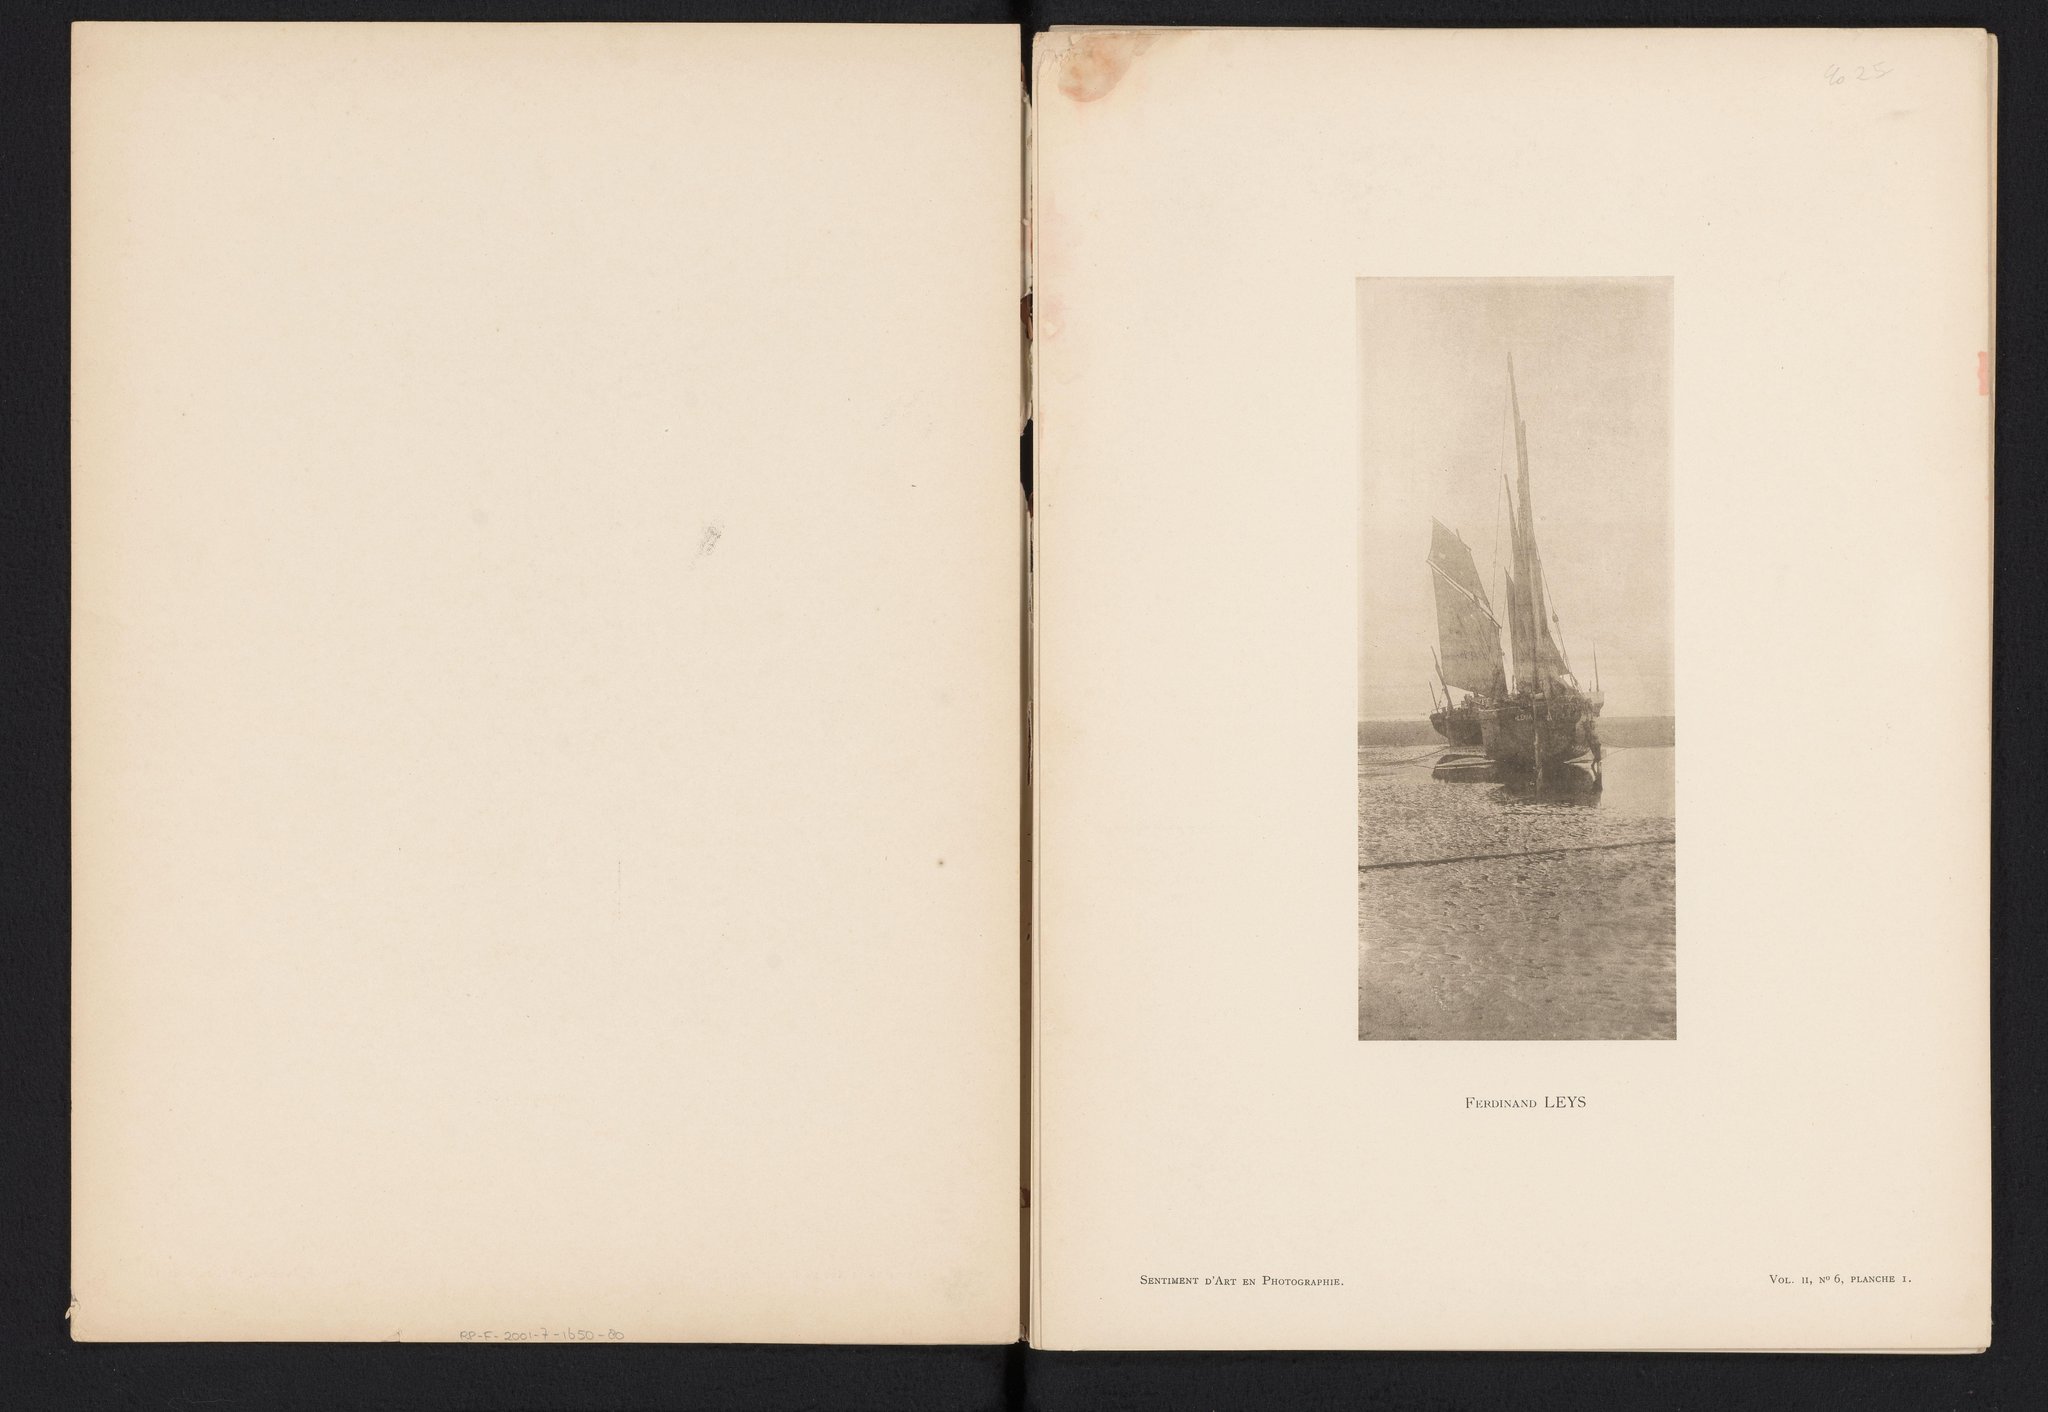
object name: photomechanical print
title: Twee zeilschepen op het strand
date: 1895-1900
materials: paper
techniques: photograph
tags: sailing-ship, sailing-boat, ships, boats on land, beached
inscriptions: number: ‘Vol. II, No 6, Planche 1.’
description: Deze prent maakt deel uit van 8 omslagen met 22 tekstbladen en 89 prenten op losse bladen in en tussen de omslagen.